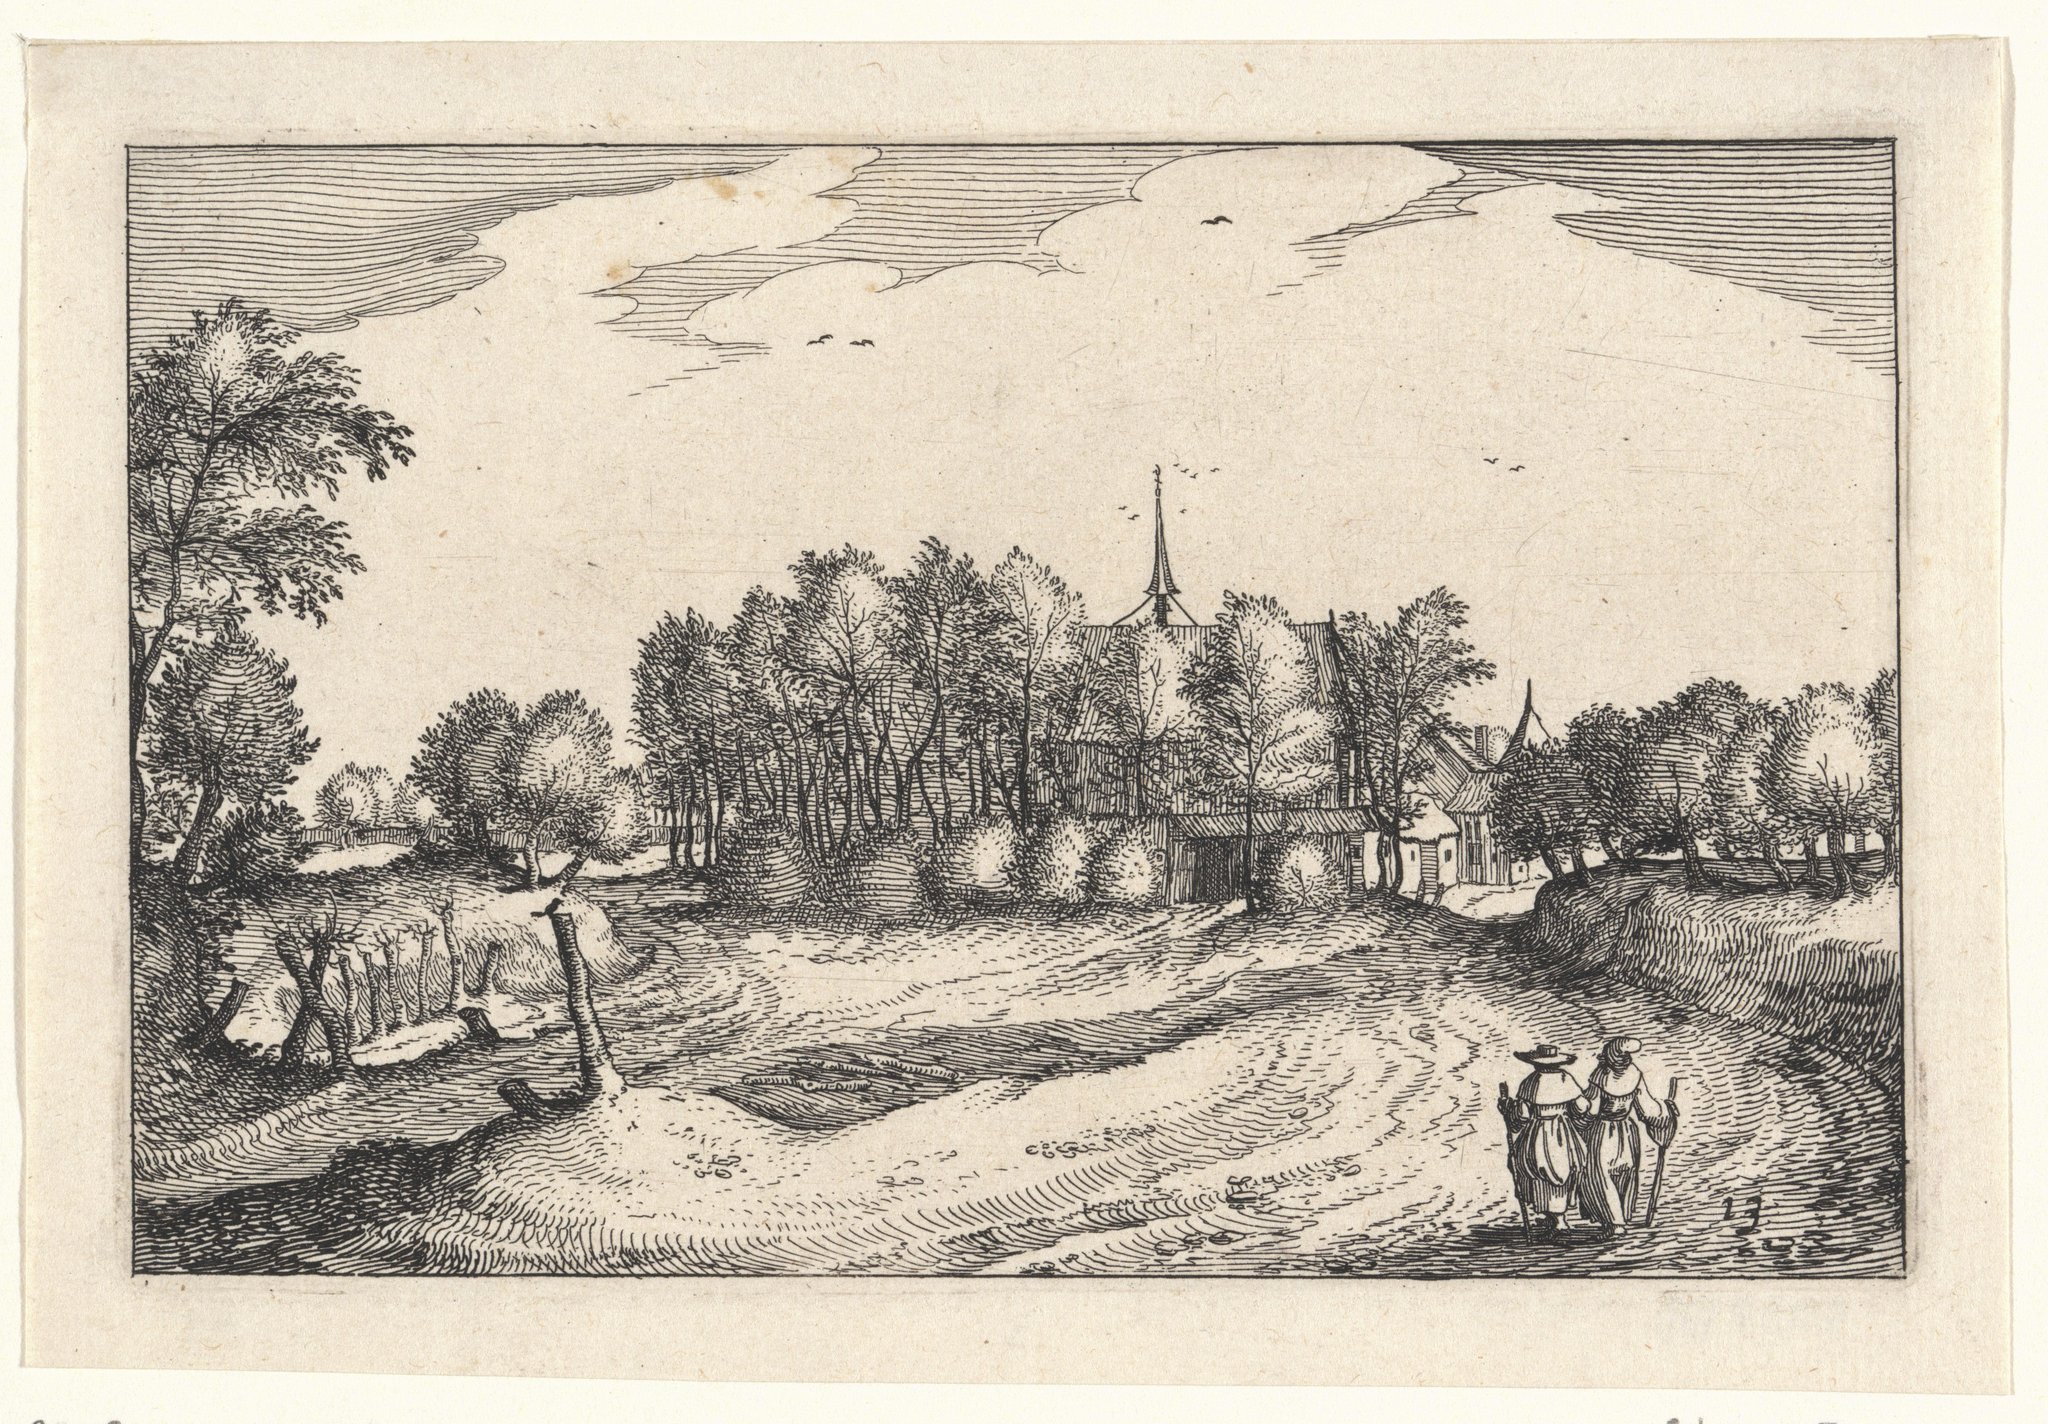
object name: print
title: Landschap met een klooster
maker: claes jansz. visscher (ii)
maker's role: draughtsman, print maker, publisher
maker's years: 1586-1652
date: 1620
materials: paper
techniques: etching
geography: amsterdam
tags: trees, birds, cloisters ~ monastery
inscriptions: collector's mark: Lugt 240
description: Gezicht om een boomrijk landschap met op de achtergrond een klooster. Rechts op de voorgrond wandelen twee vrouwen en links zit een vogel op een afgehakte boom.